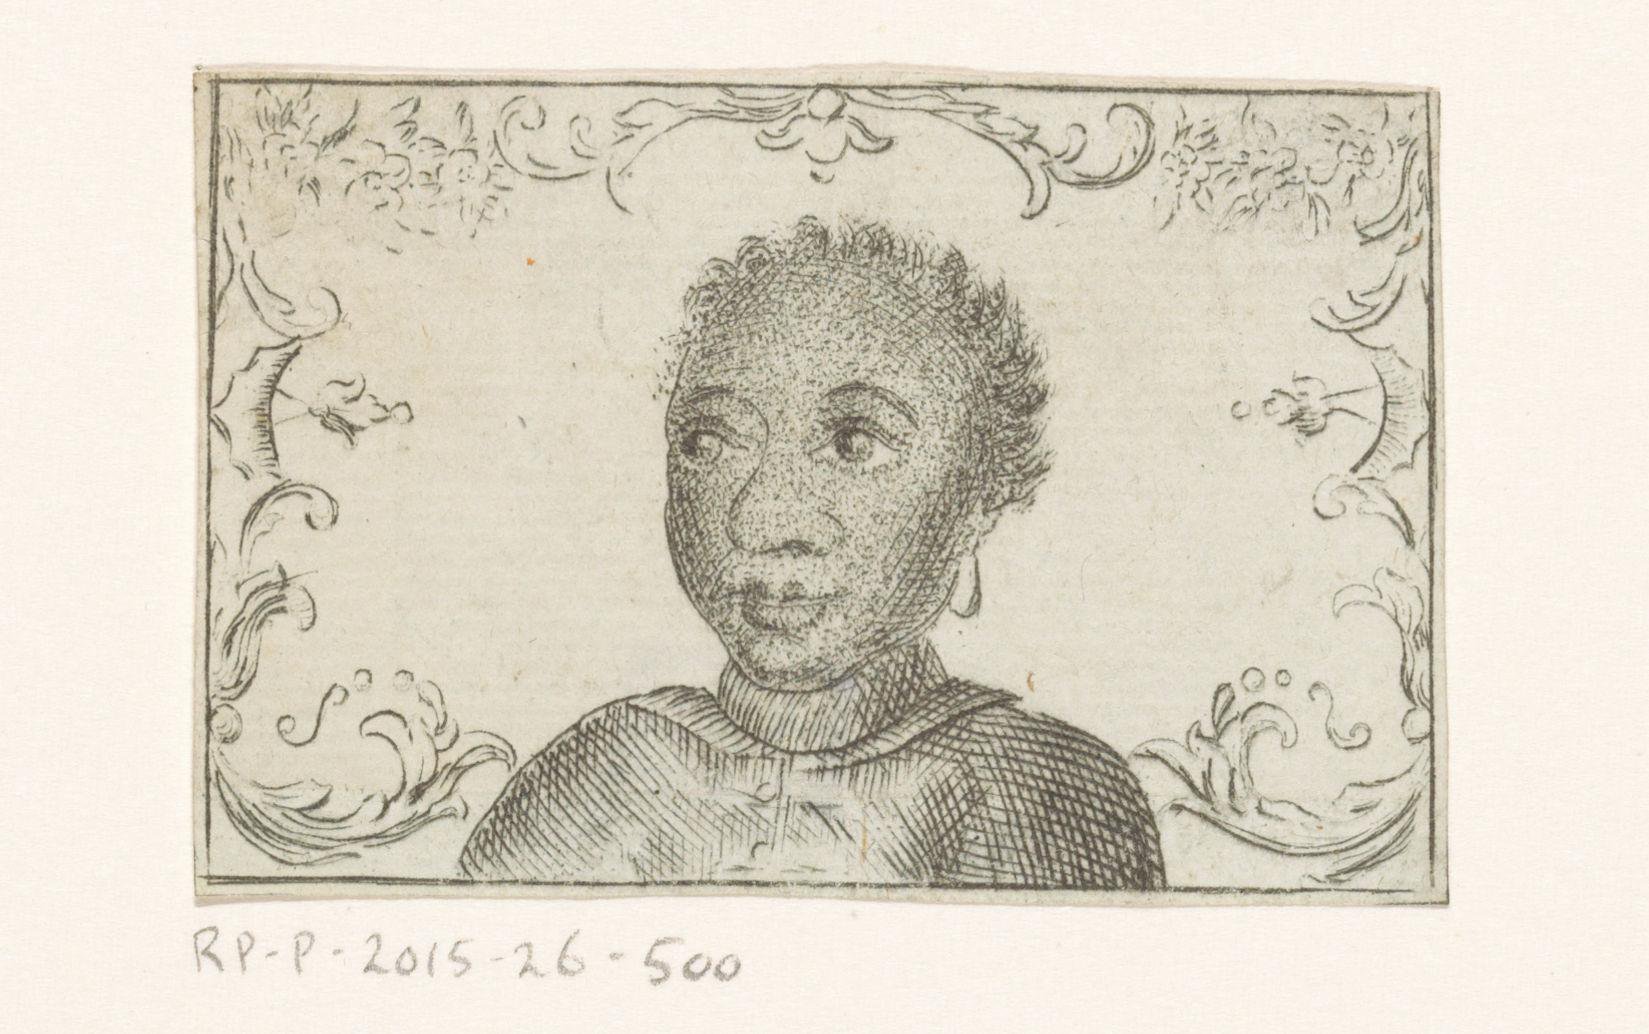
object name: label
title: Etiket van à la Tête Noir, leverancier van schrijfbenodigdheden te Rouen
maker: Anonymous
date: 1775-1825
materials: paper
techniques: letterpress printing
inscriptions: collector's mark: Lugt 4779, collector's mark: Lugt 2228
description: Mogelijk is er een verband tussen dit etiket en een prent met het gezicht van een zwarte vrouw in een omlijsting (RP-P-2015-26-500).